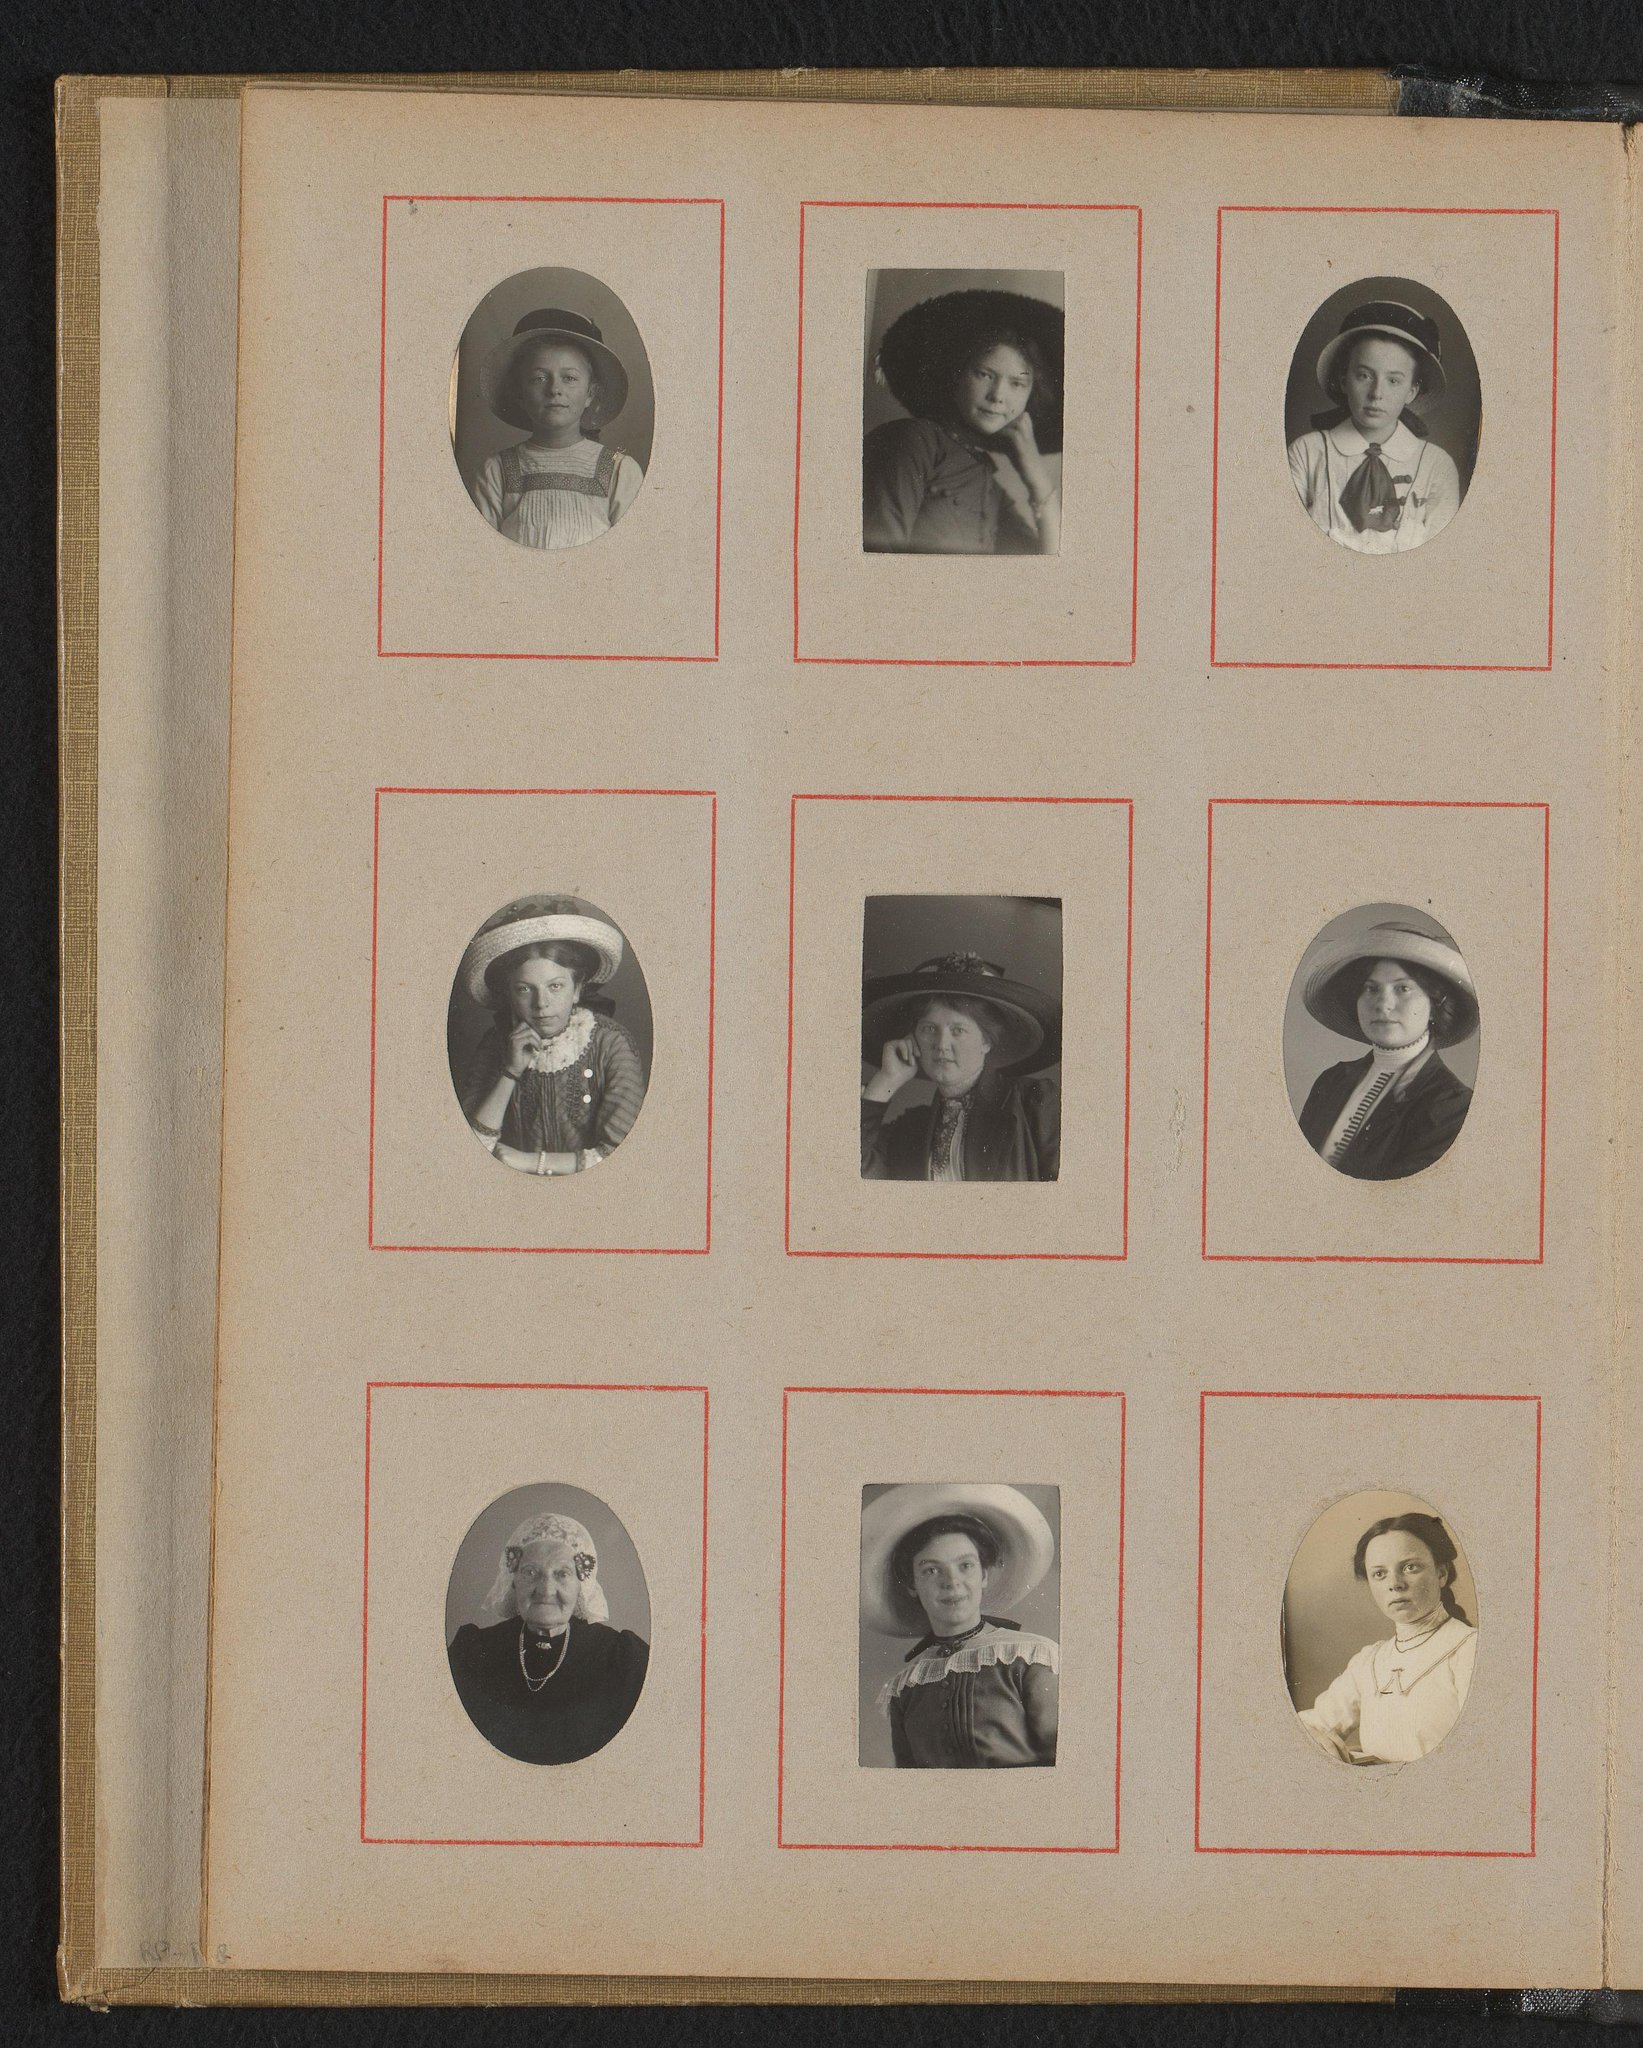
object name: snapshot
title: Vijf portretten van meisjes en vier portretten van vrouwen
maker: Anonymous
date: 1900-1920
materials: cardboard, paper, photographic support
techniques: gelatin silver print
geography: netherlands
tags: adolescent, young woman, maiden, historical persons - bb - woman, girl (child between toddler and youth), head-gear: hat, folk costume, regional costume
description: Deze foto's maken deel uit van een album.